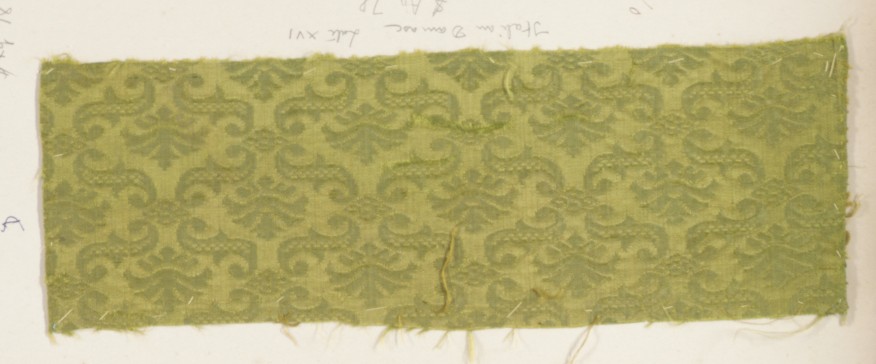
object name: fragment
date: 1567-1600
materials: silk